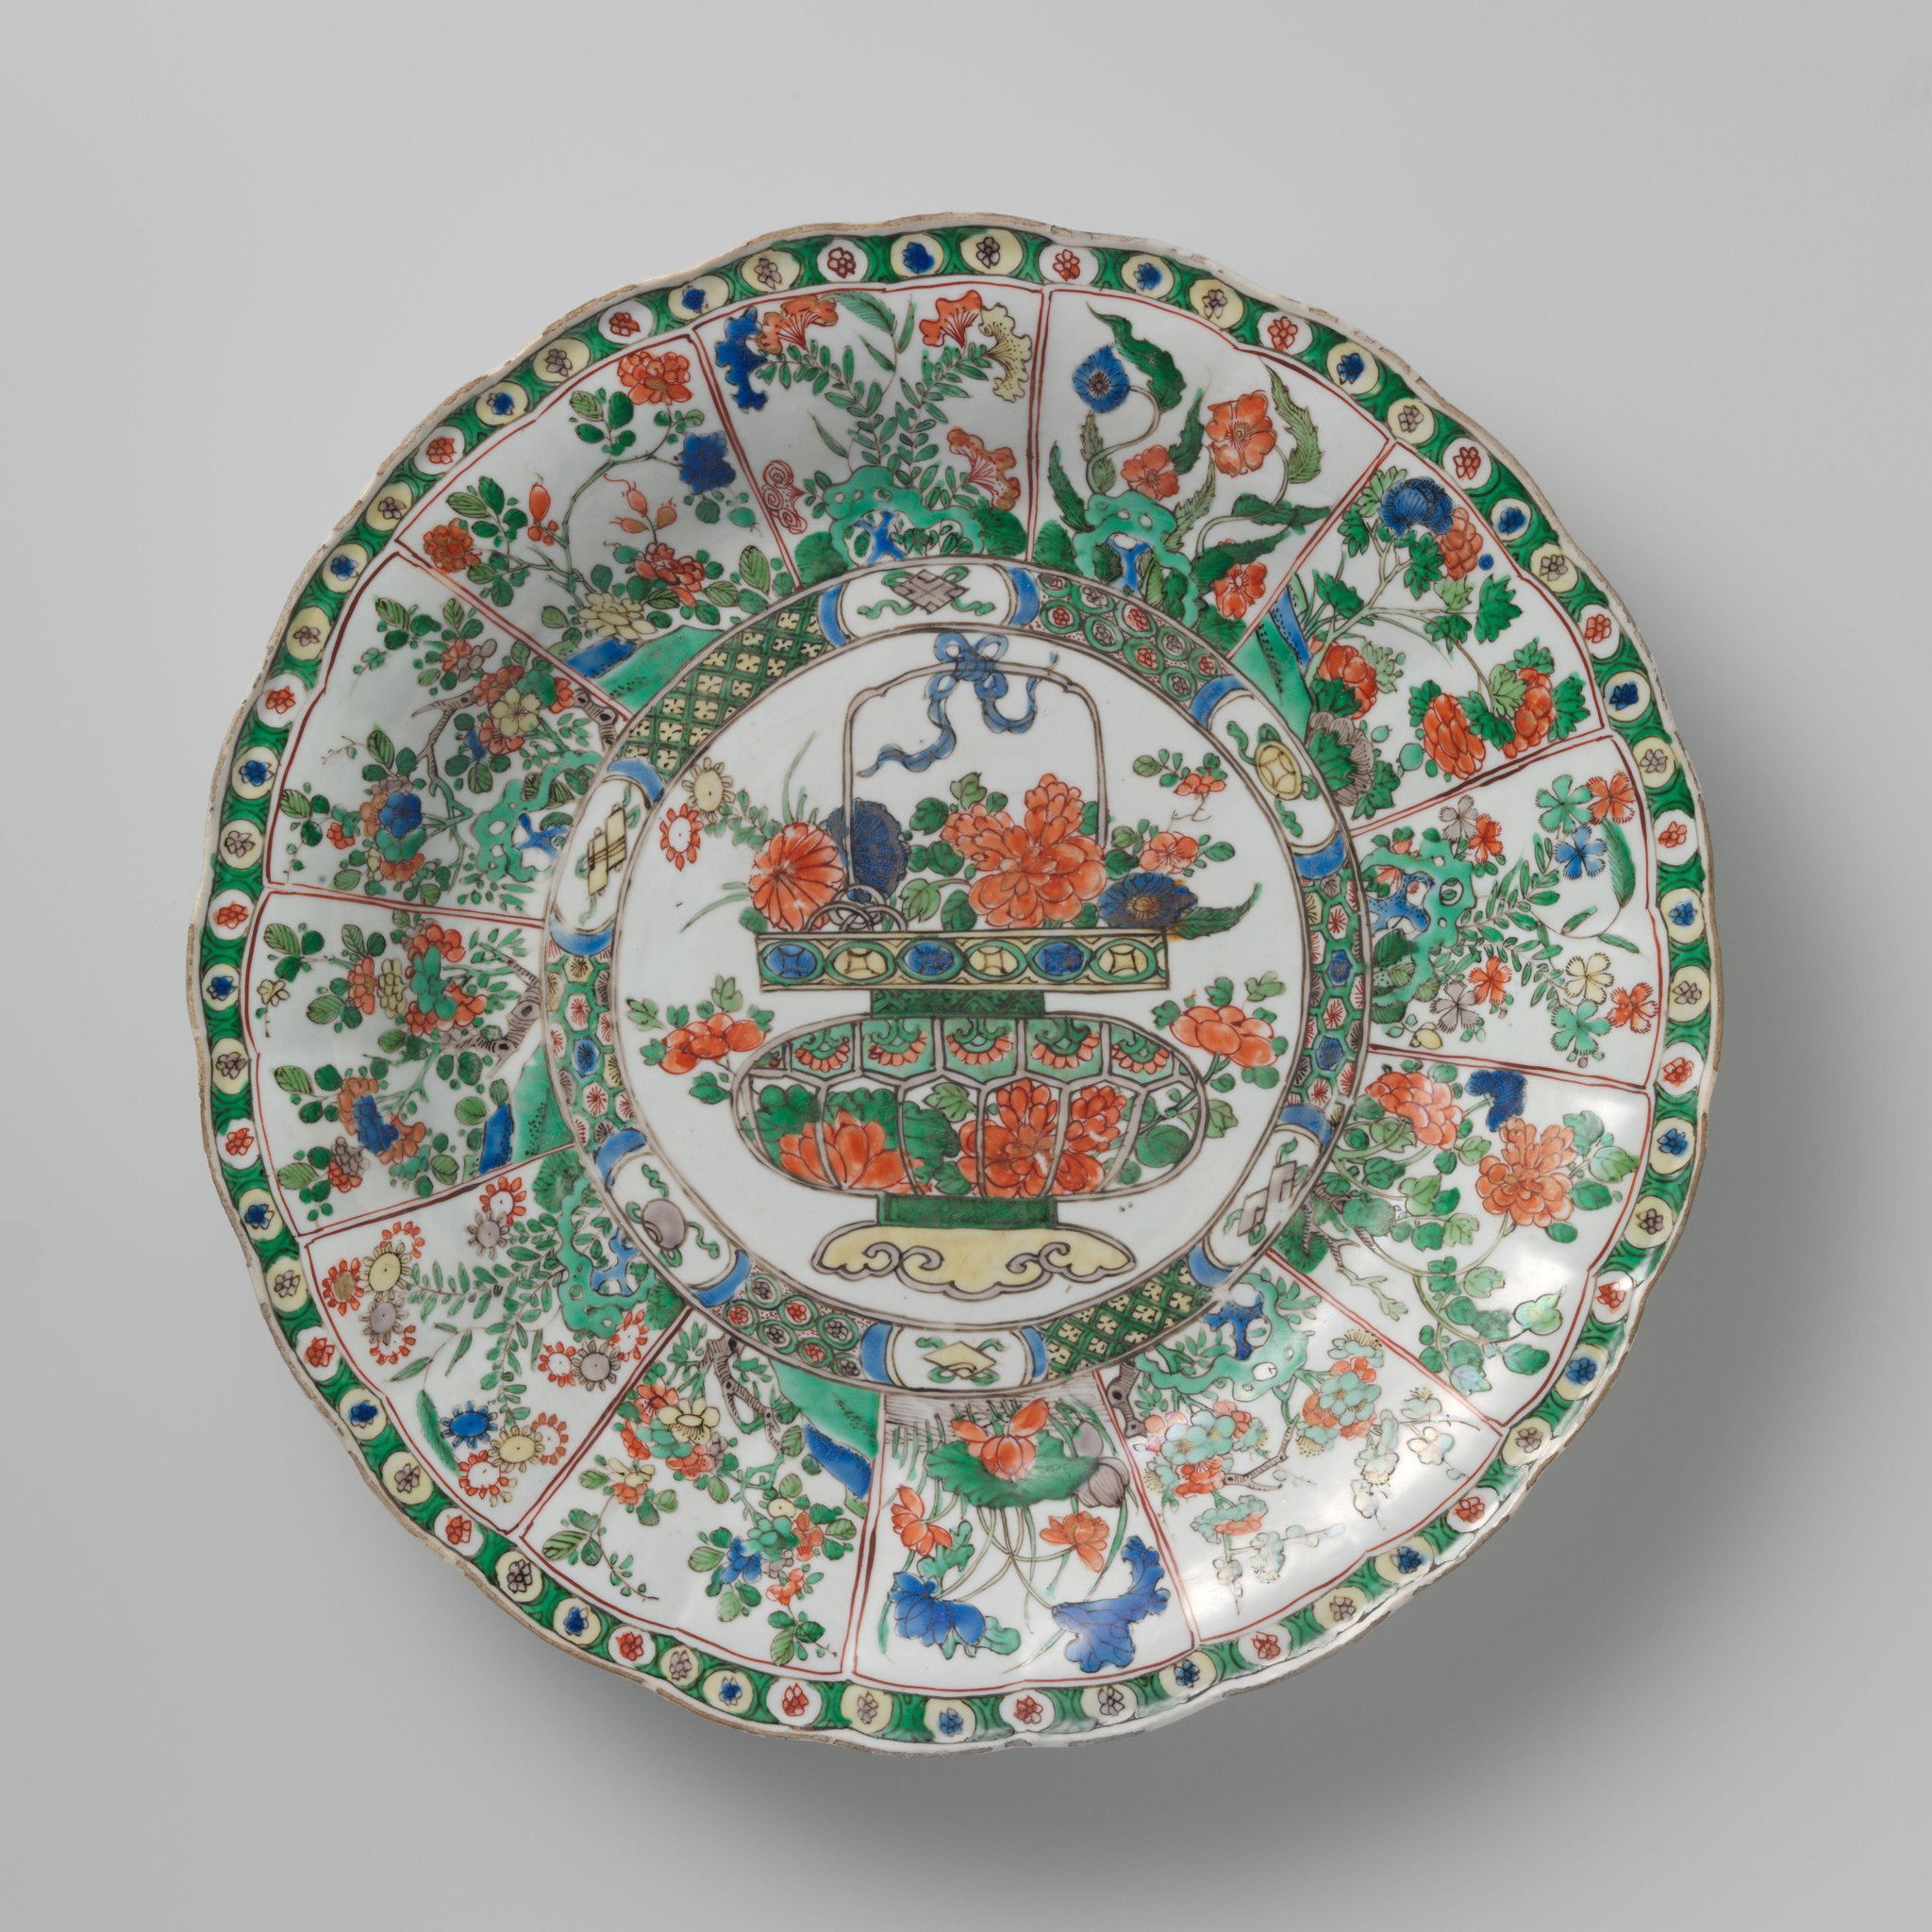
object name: platter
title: Dish with flower basket, precious objects and flowering plants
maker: Anonymous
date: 1700-1724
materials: cobalt, glaze, gold, paint, porcelain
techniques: firing, gilding, turning, vitrification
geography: china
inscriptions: mark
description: Schotel van porselein met geribde wand en gelobde rand, beschilderd in onderglazuur blauw en op het glazuur met blauw, rood, groen, geel, aubergine, zwart en goud. Op het plat een bloemenmand (pioen, chrysant, aster, lotus). Om de mand een band met servetwerk onderbroken door zes cartouches met kostbaarheden (ruit, parel, boeken, munt, rollen). Vanuit deze band twaalf bloembladvormige vakken op de wand met bloeiende planten; op de rand een band met bloemen in medaillons. De buitenwand met drie bloemtakken. Gemerkt op de onderzijde met een zegelmerk in een dubbele cirkel. Famille verte.